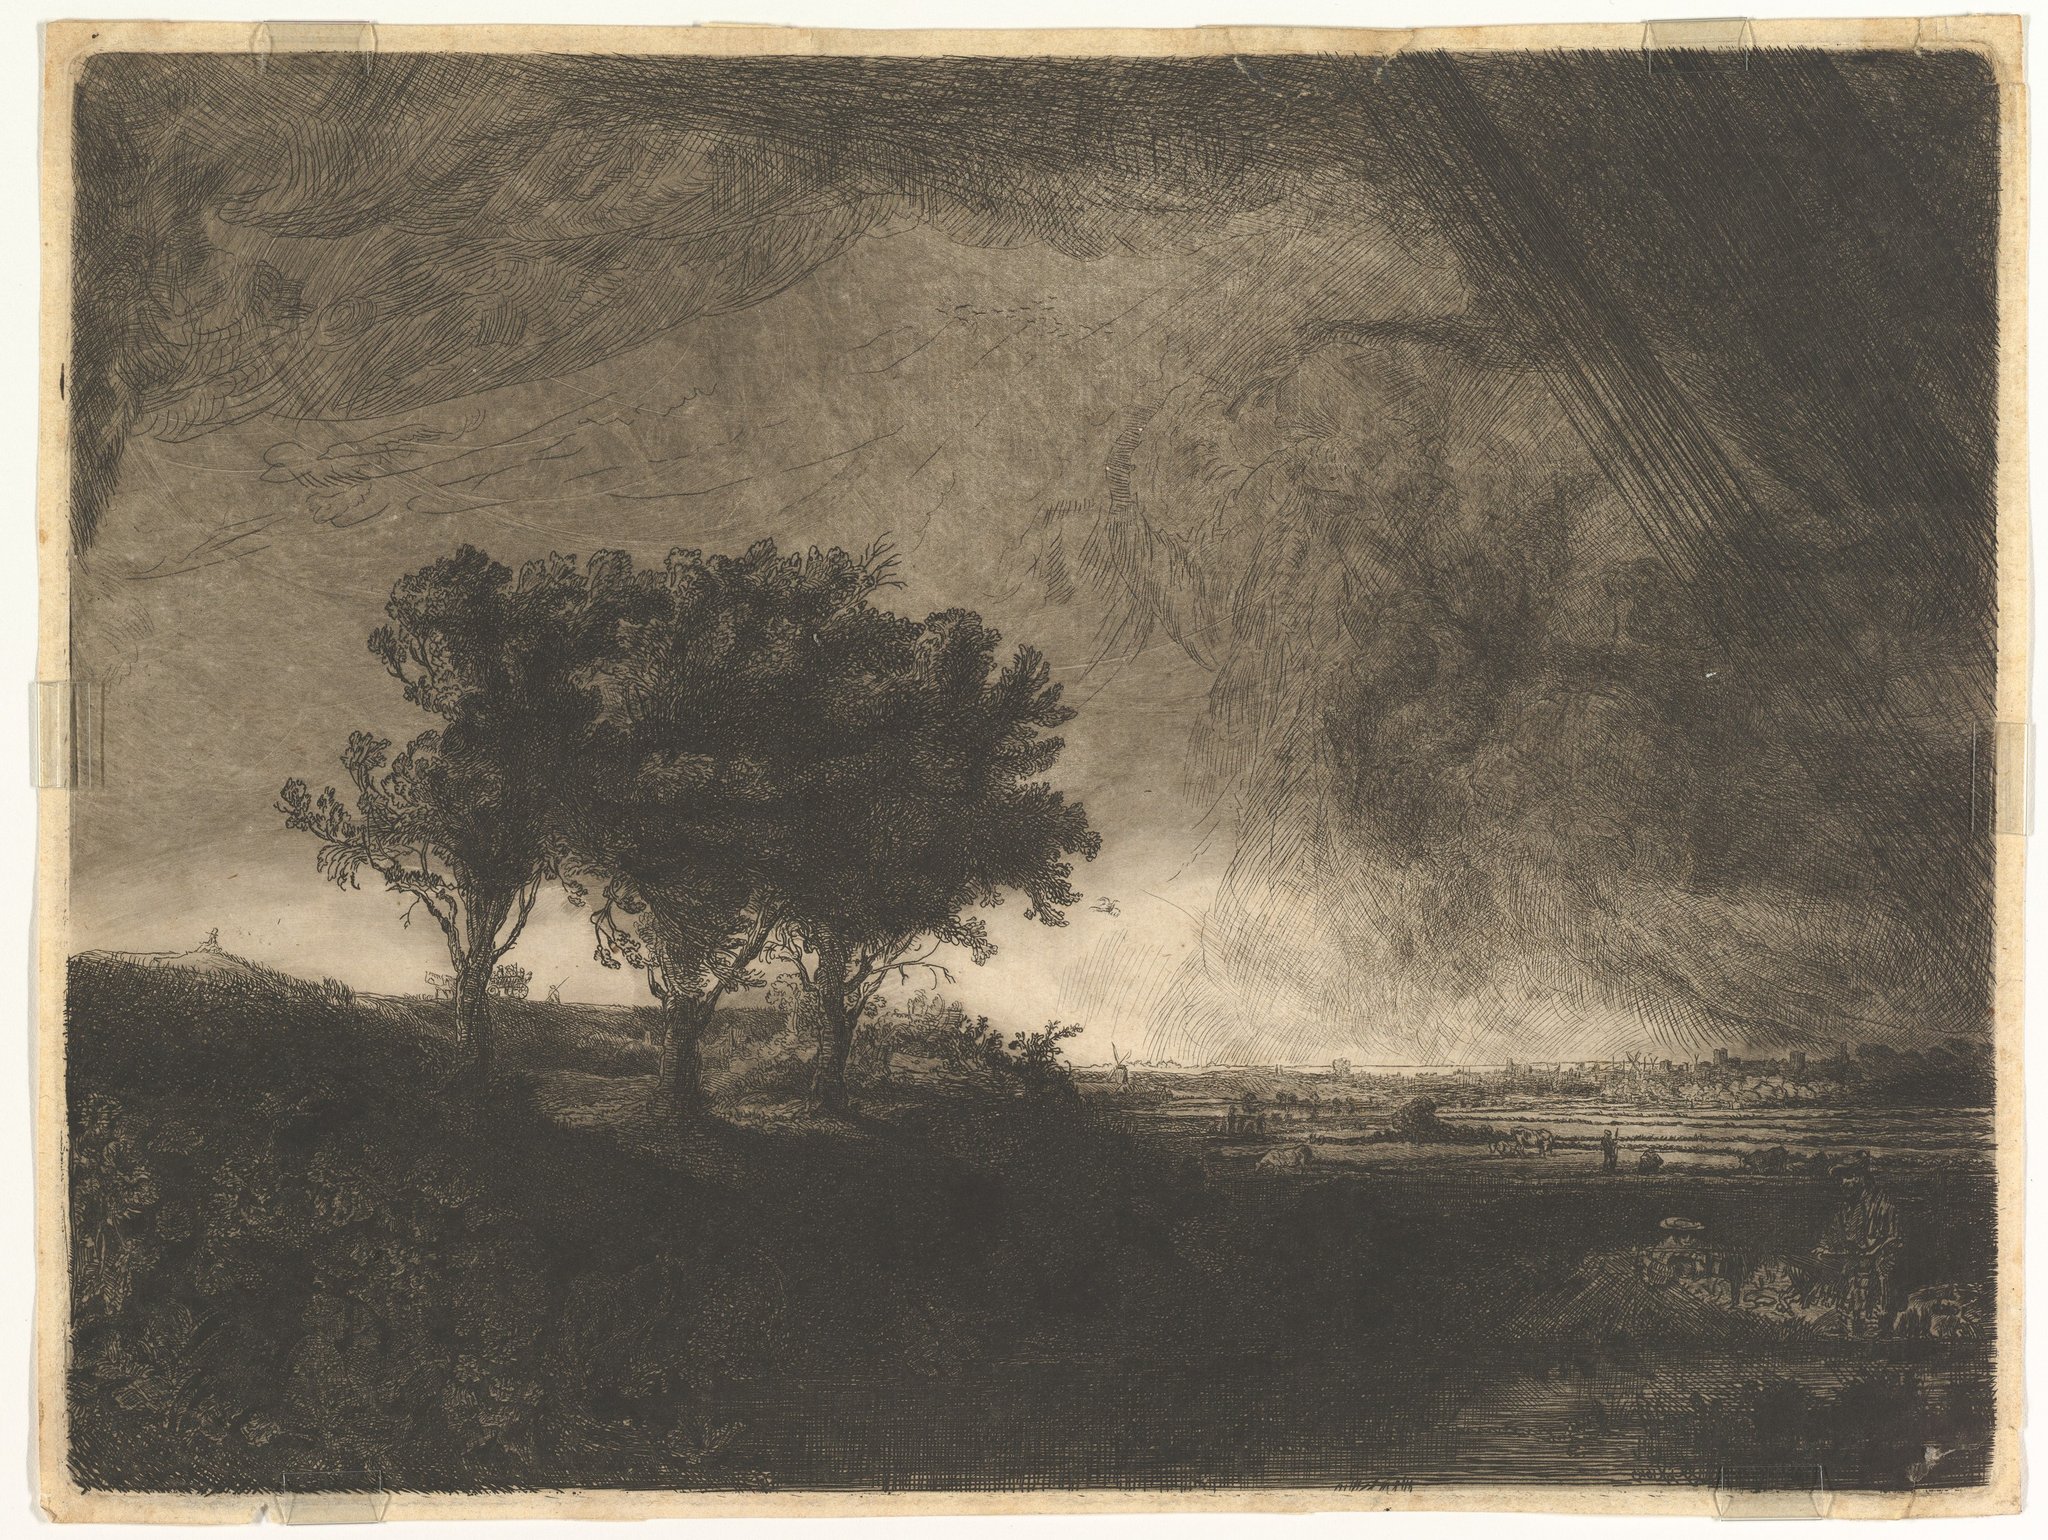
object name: print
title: The Three Trees, after Rembrandt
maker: william baillie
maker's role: artist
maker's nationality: irish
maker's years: 1723-1810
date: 1758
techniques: etching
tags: landscapes,trees